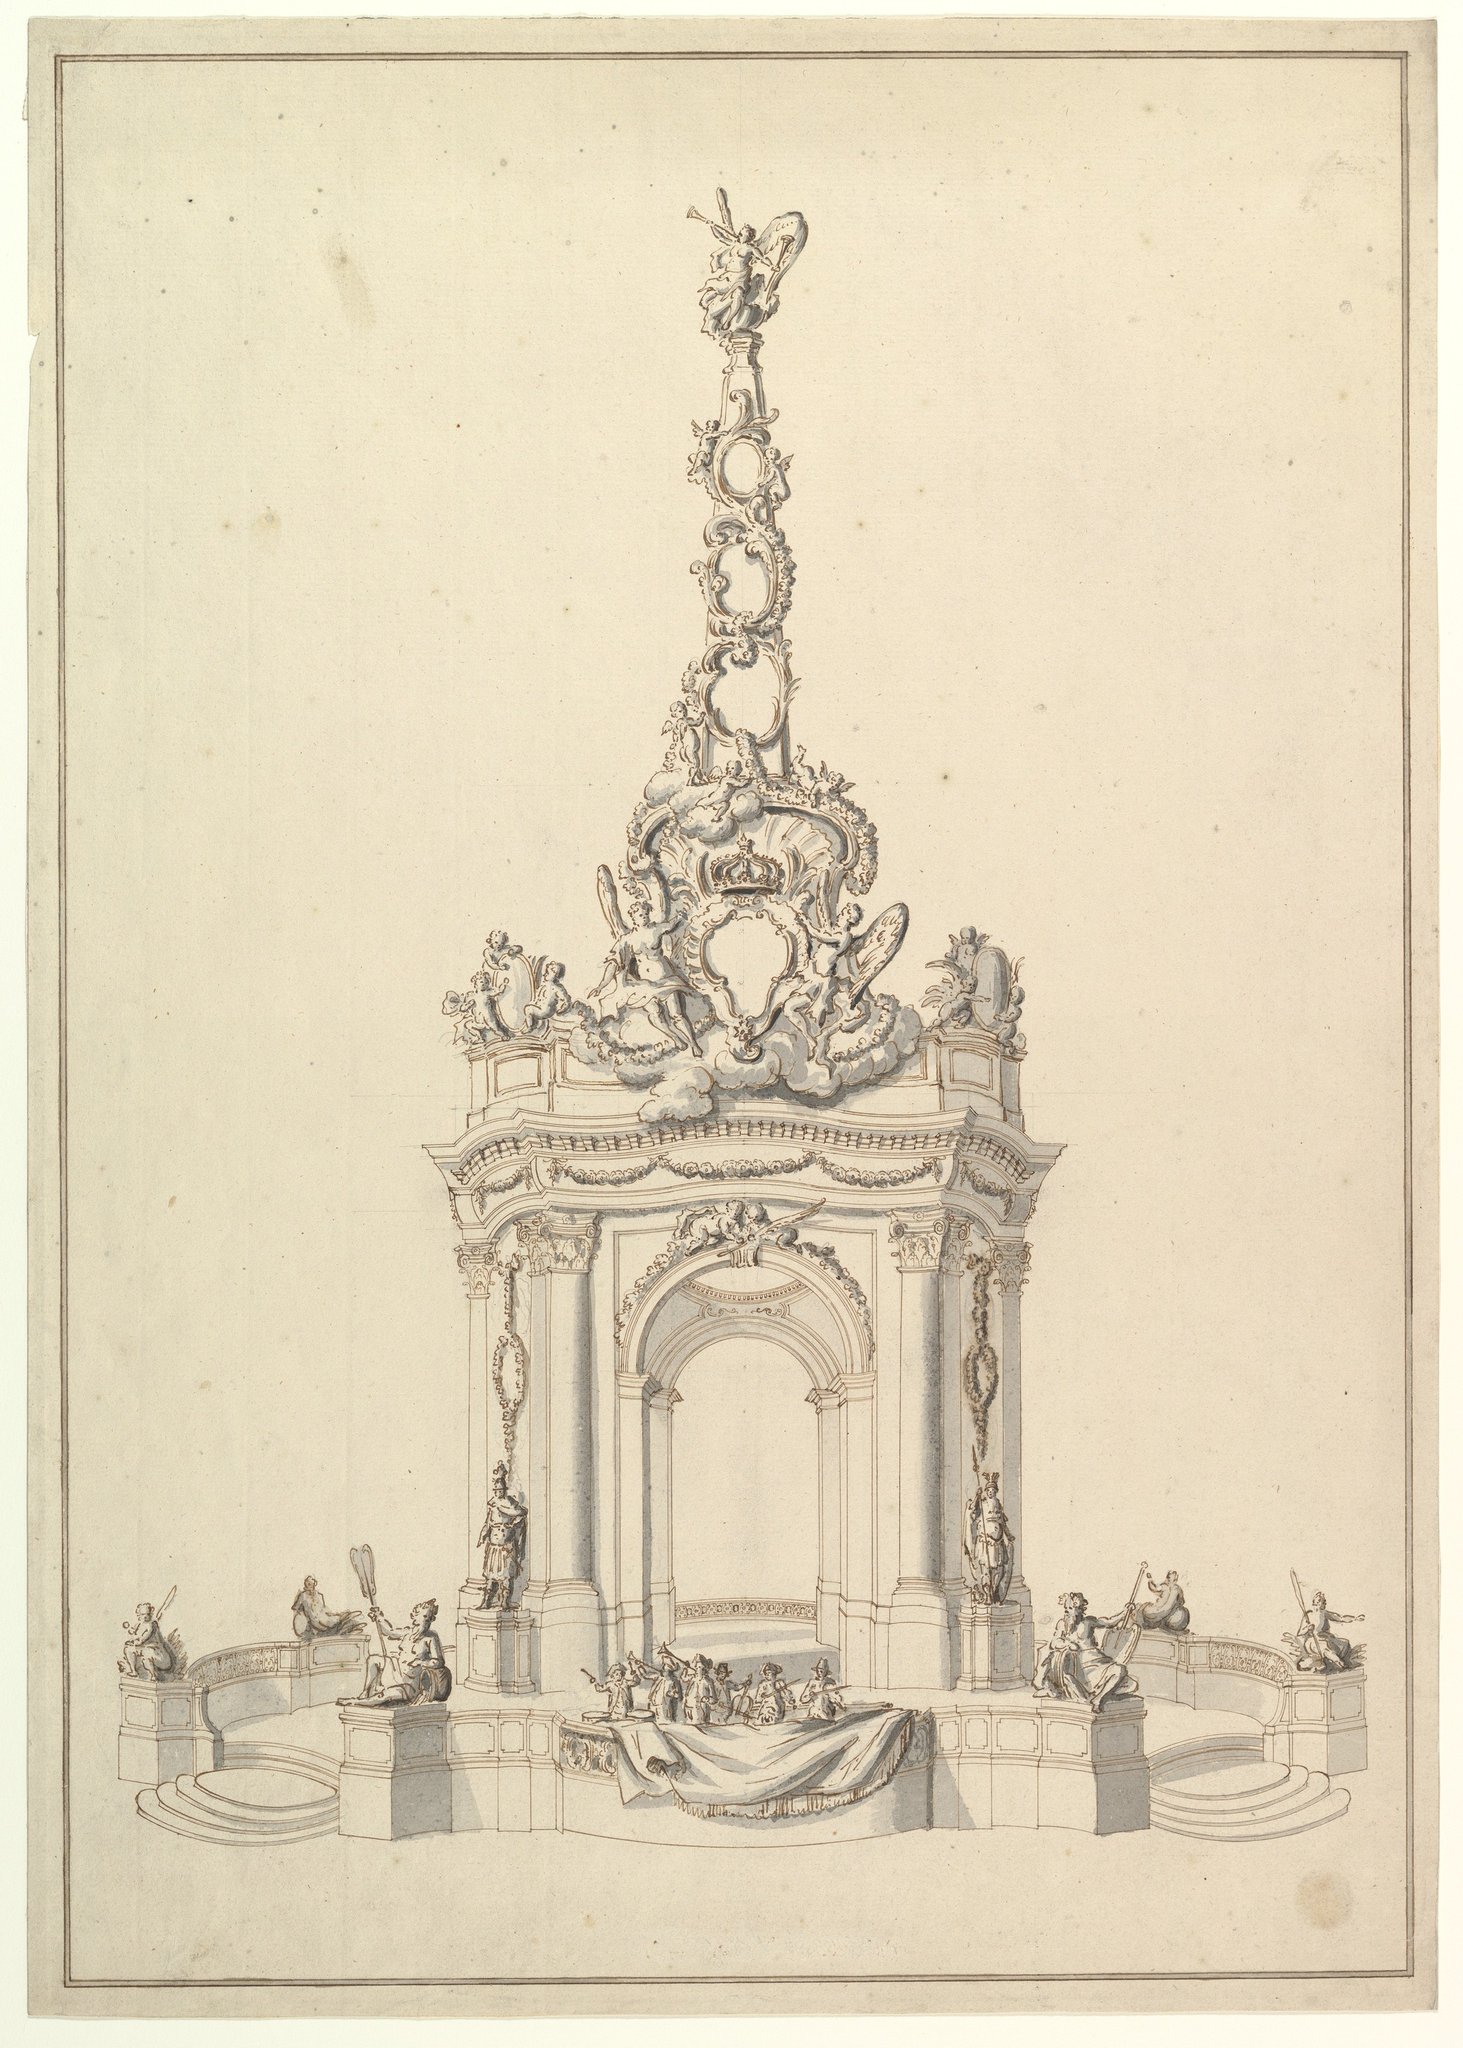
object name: drawing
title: Design for a Festival Monument: Base Holds a Small Orchestra; Triumphal Arch Surmounted by a Cartouche-Decorated Pyramid with Figure of Fame, below, a Royal Crown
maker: anonymous, italian, 18th century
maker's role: artist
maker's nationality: italian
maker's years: 1700-1800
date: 1701-1800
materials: ink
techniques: pen, wash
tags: monuments,men,musicians